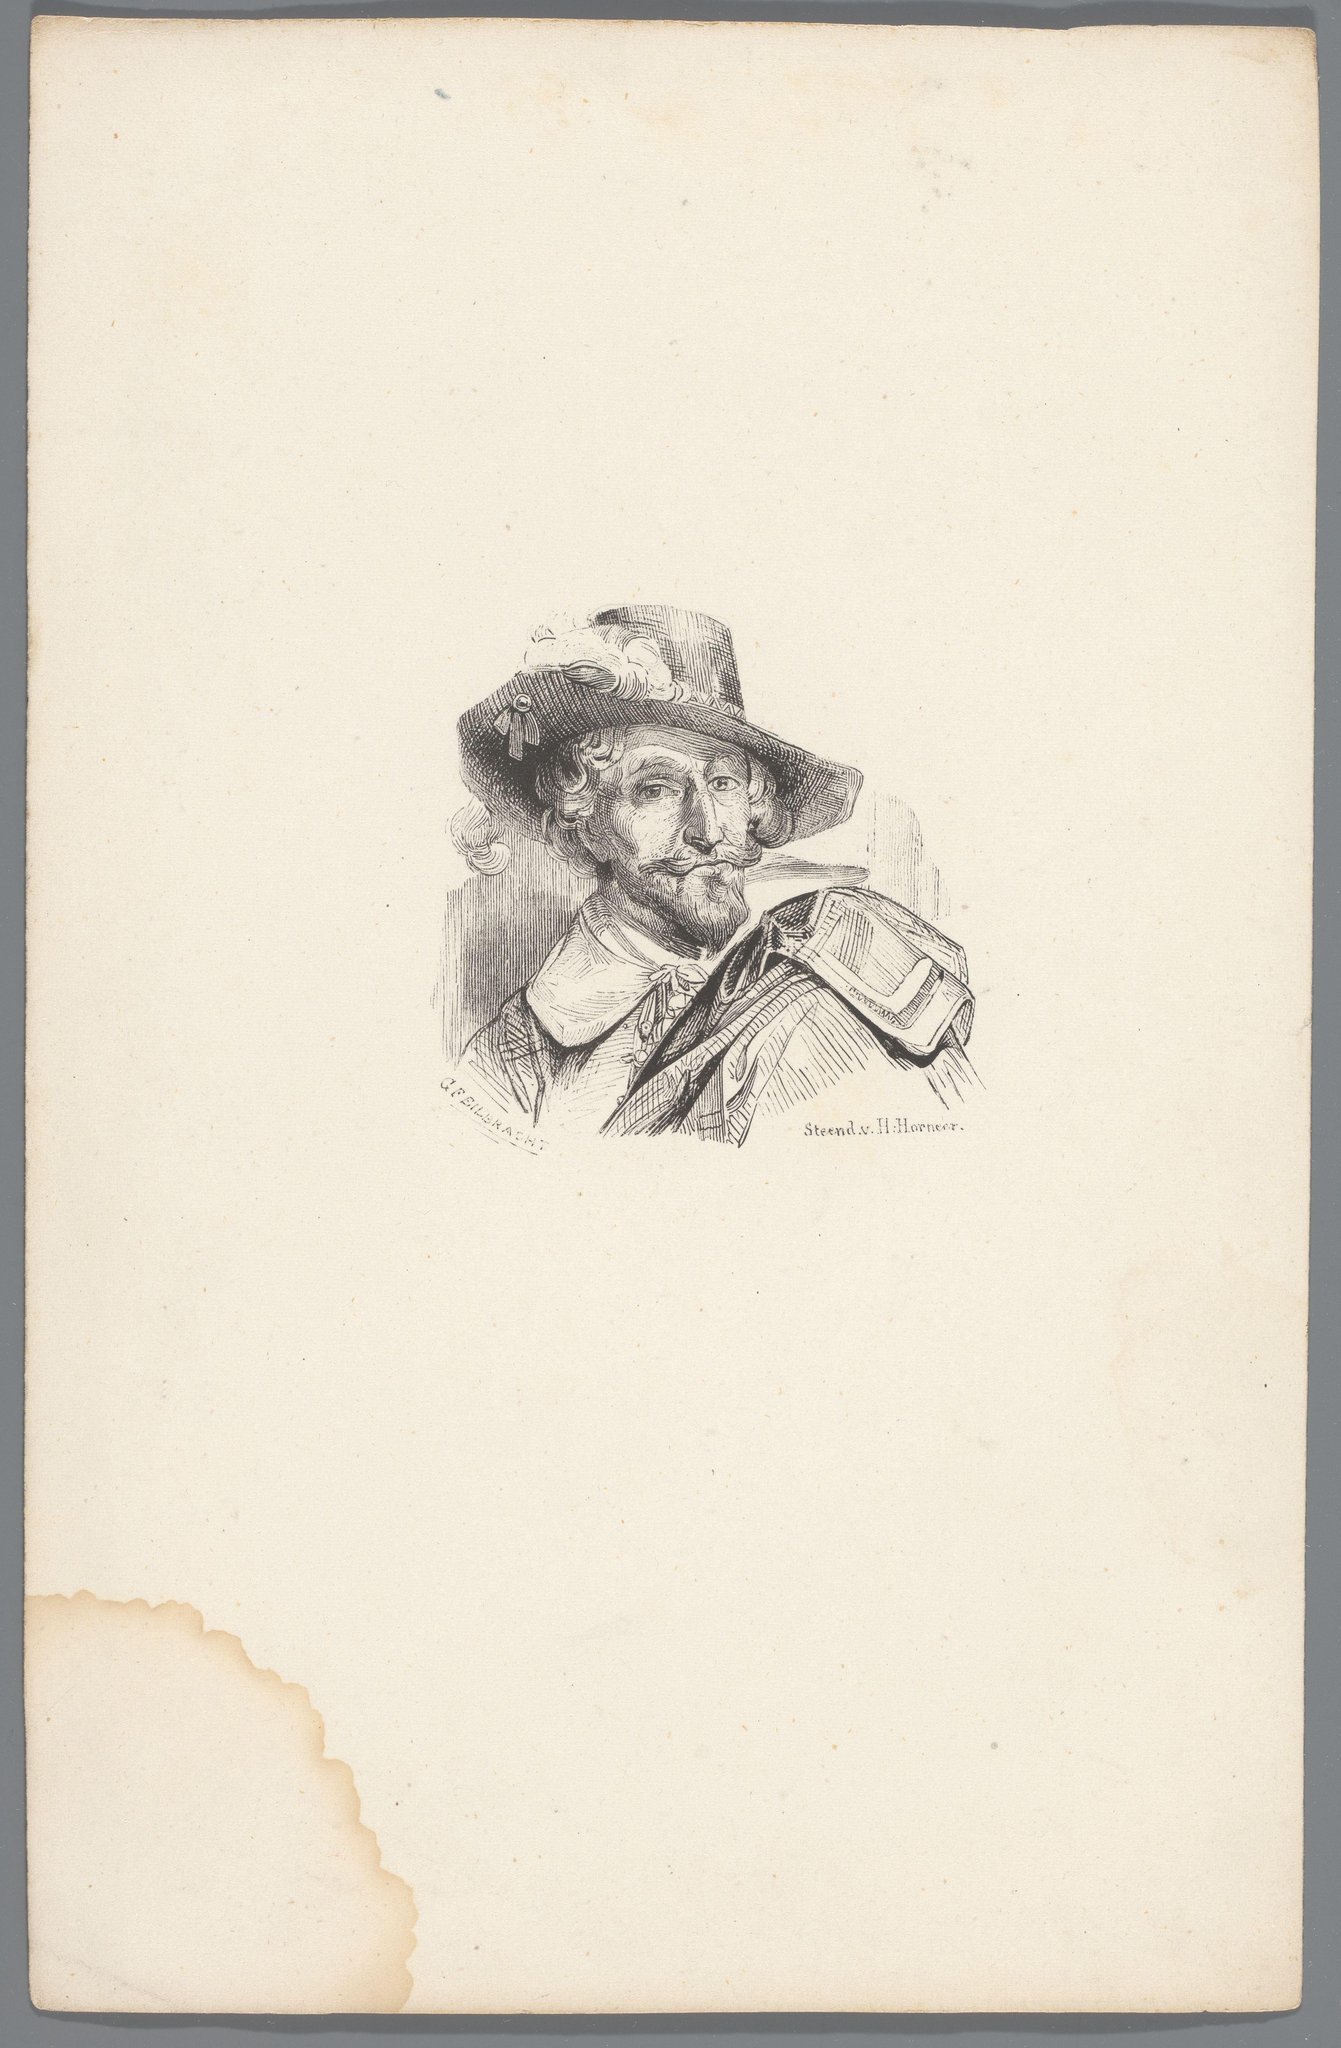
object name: wrapper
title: Twaalf platen naar de oorspronkelijke teekeningen van Nicaise de Keizer, in steen gebragt door G.F. Eilbracht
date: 1844-1854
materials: paper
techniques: lithograph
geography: netherlands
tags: (scenes from) specific works of literature (with author, title)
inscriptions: collector's mark: Lugt 2228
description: Buste van oude man met verenhoed. Los blad in een mapje met twaalf lithografieën naar de houtgravures gebruikt als illustraties in: Félix Bogaerts, El Maestro del Campo, 1839.